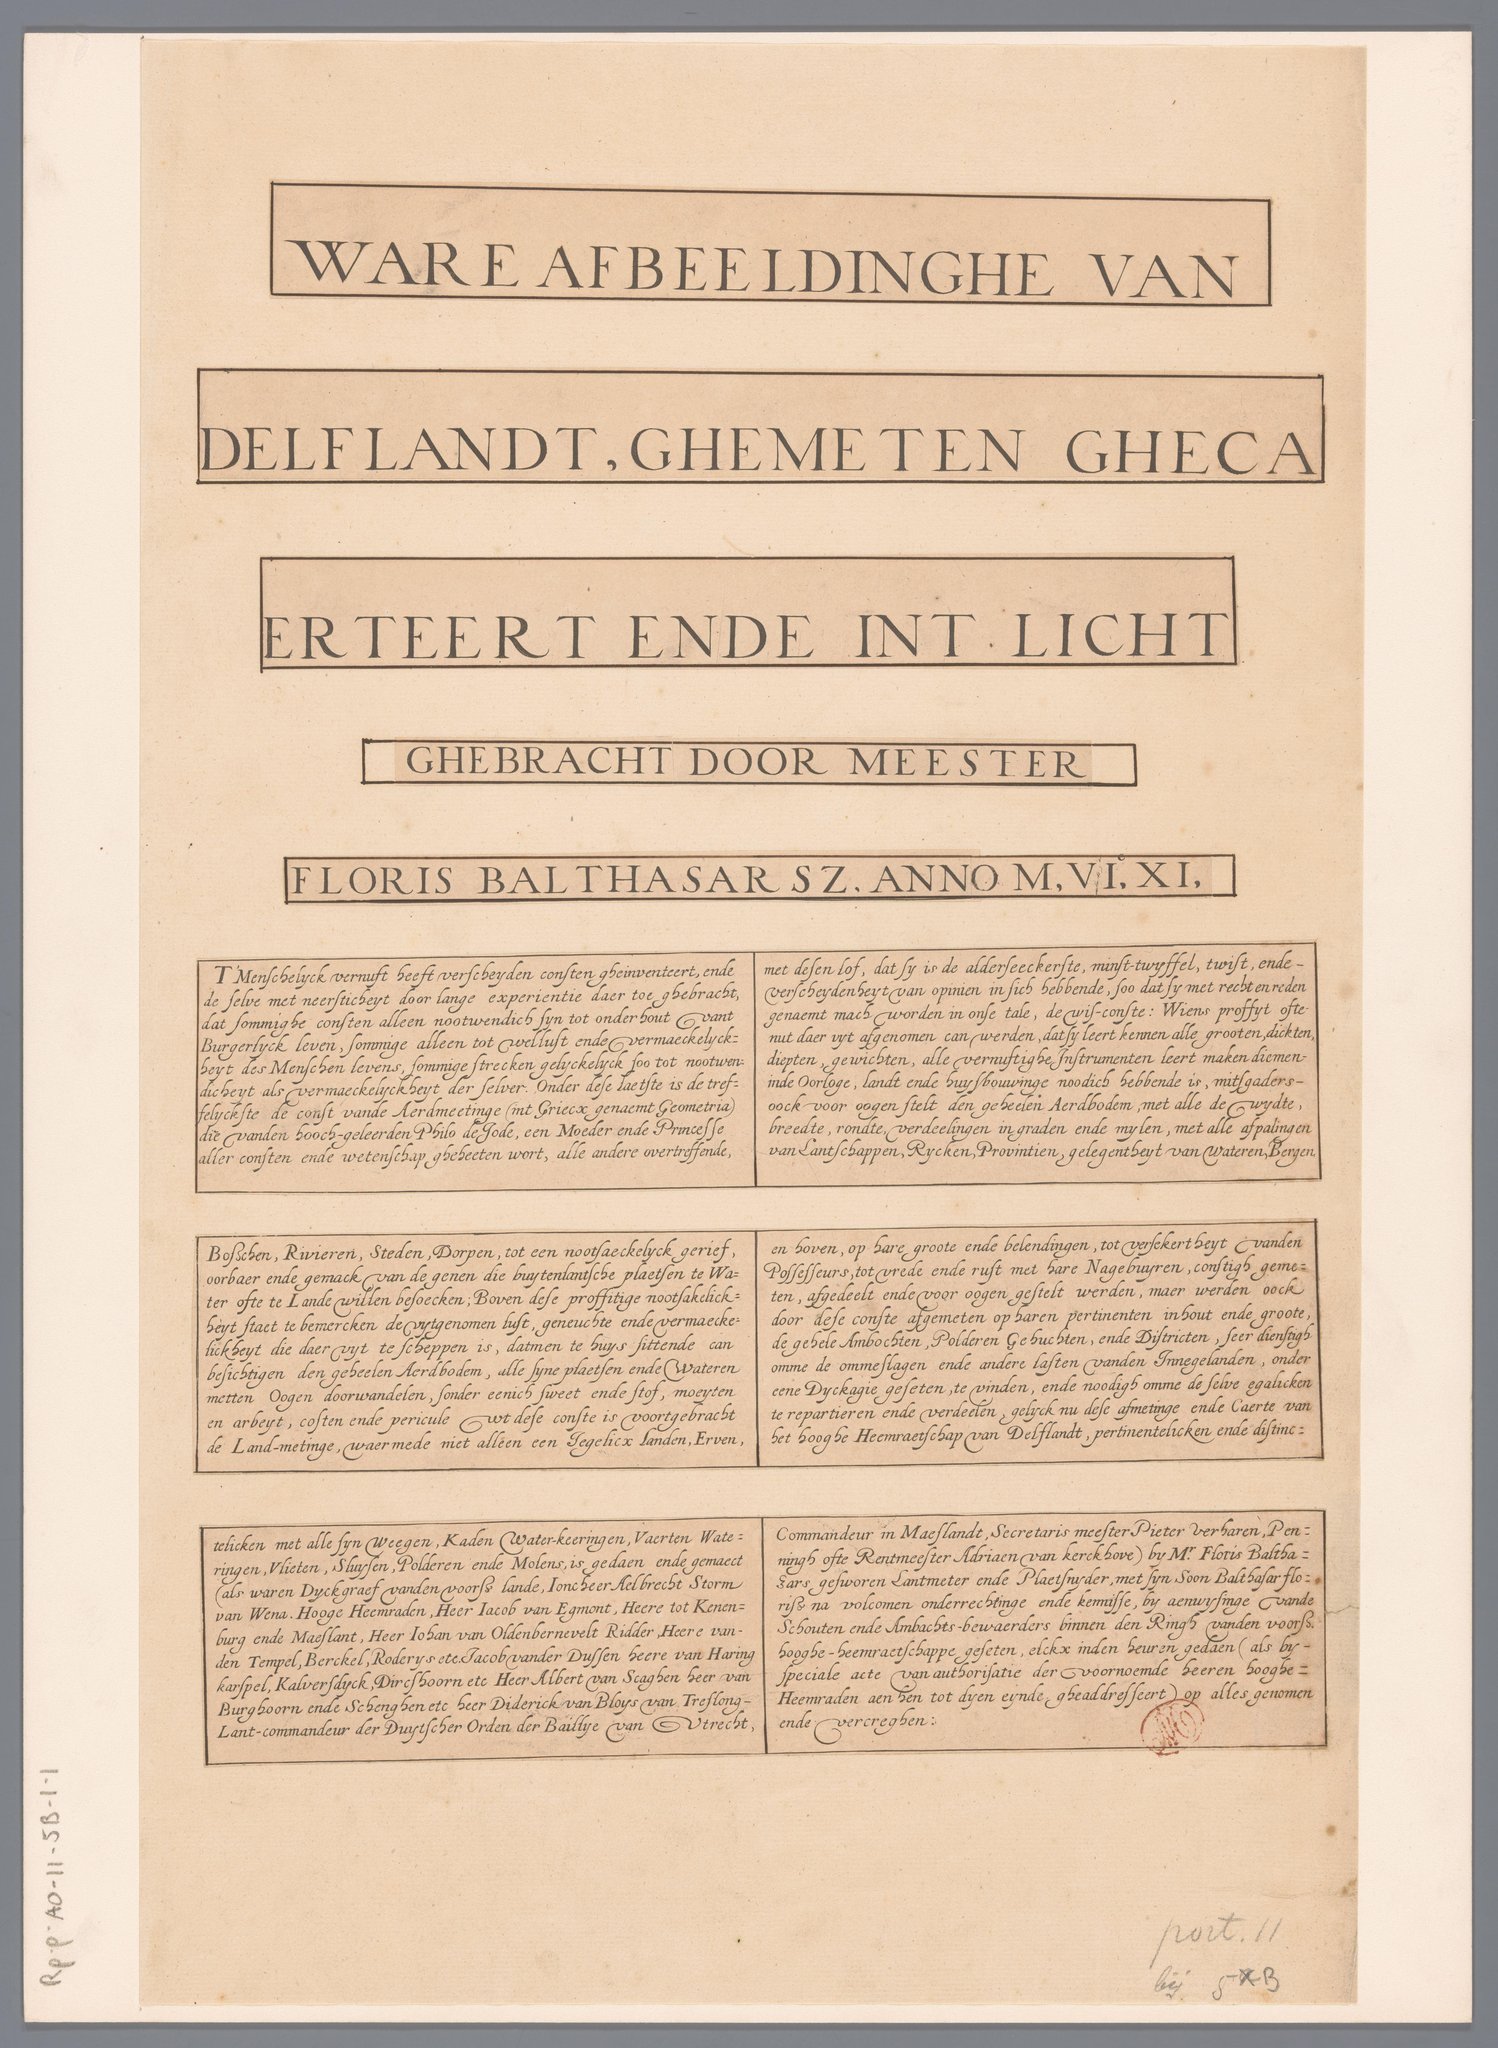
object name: print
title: Titel en tekst bij Floris Balthasarsz. van Berckenrodes kaart van het Hoogheemraadschap van Delfland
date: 1611-1692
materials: paper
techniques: engraving, etching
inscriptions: collector's mark: Lugt 195